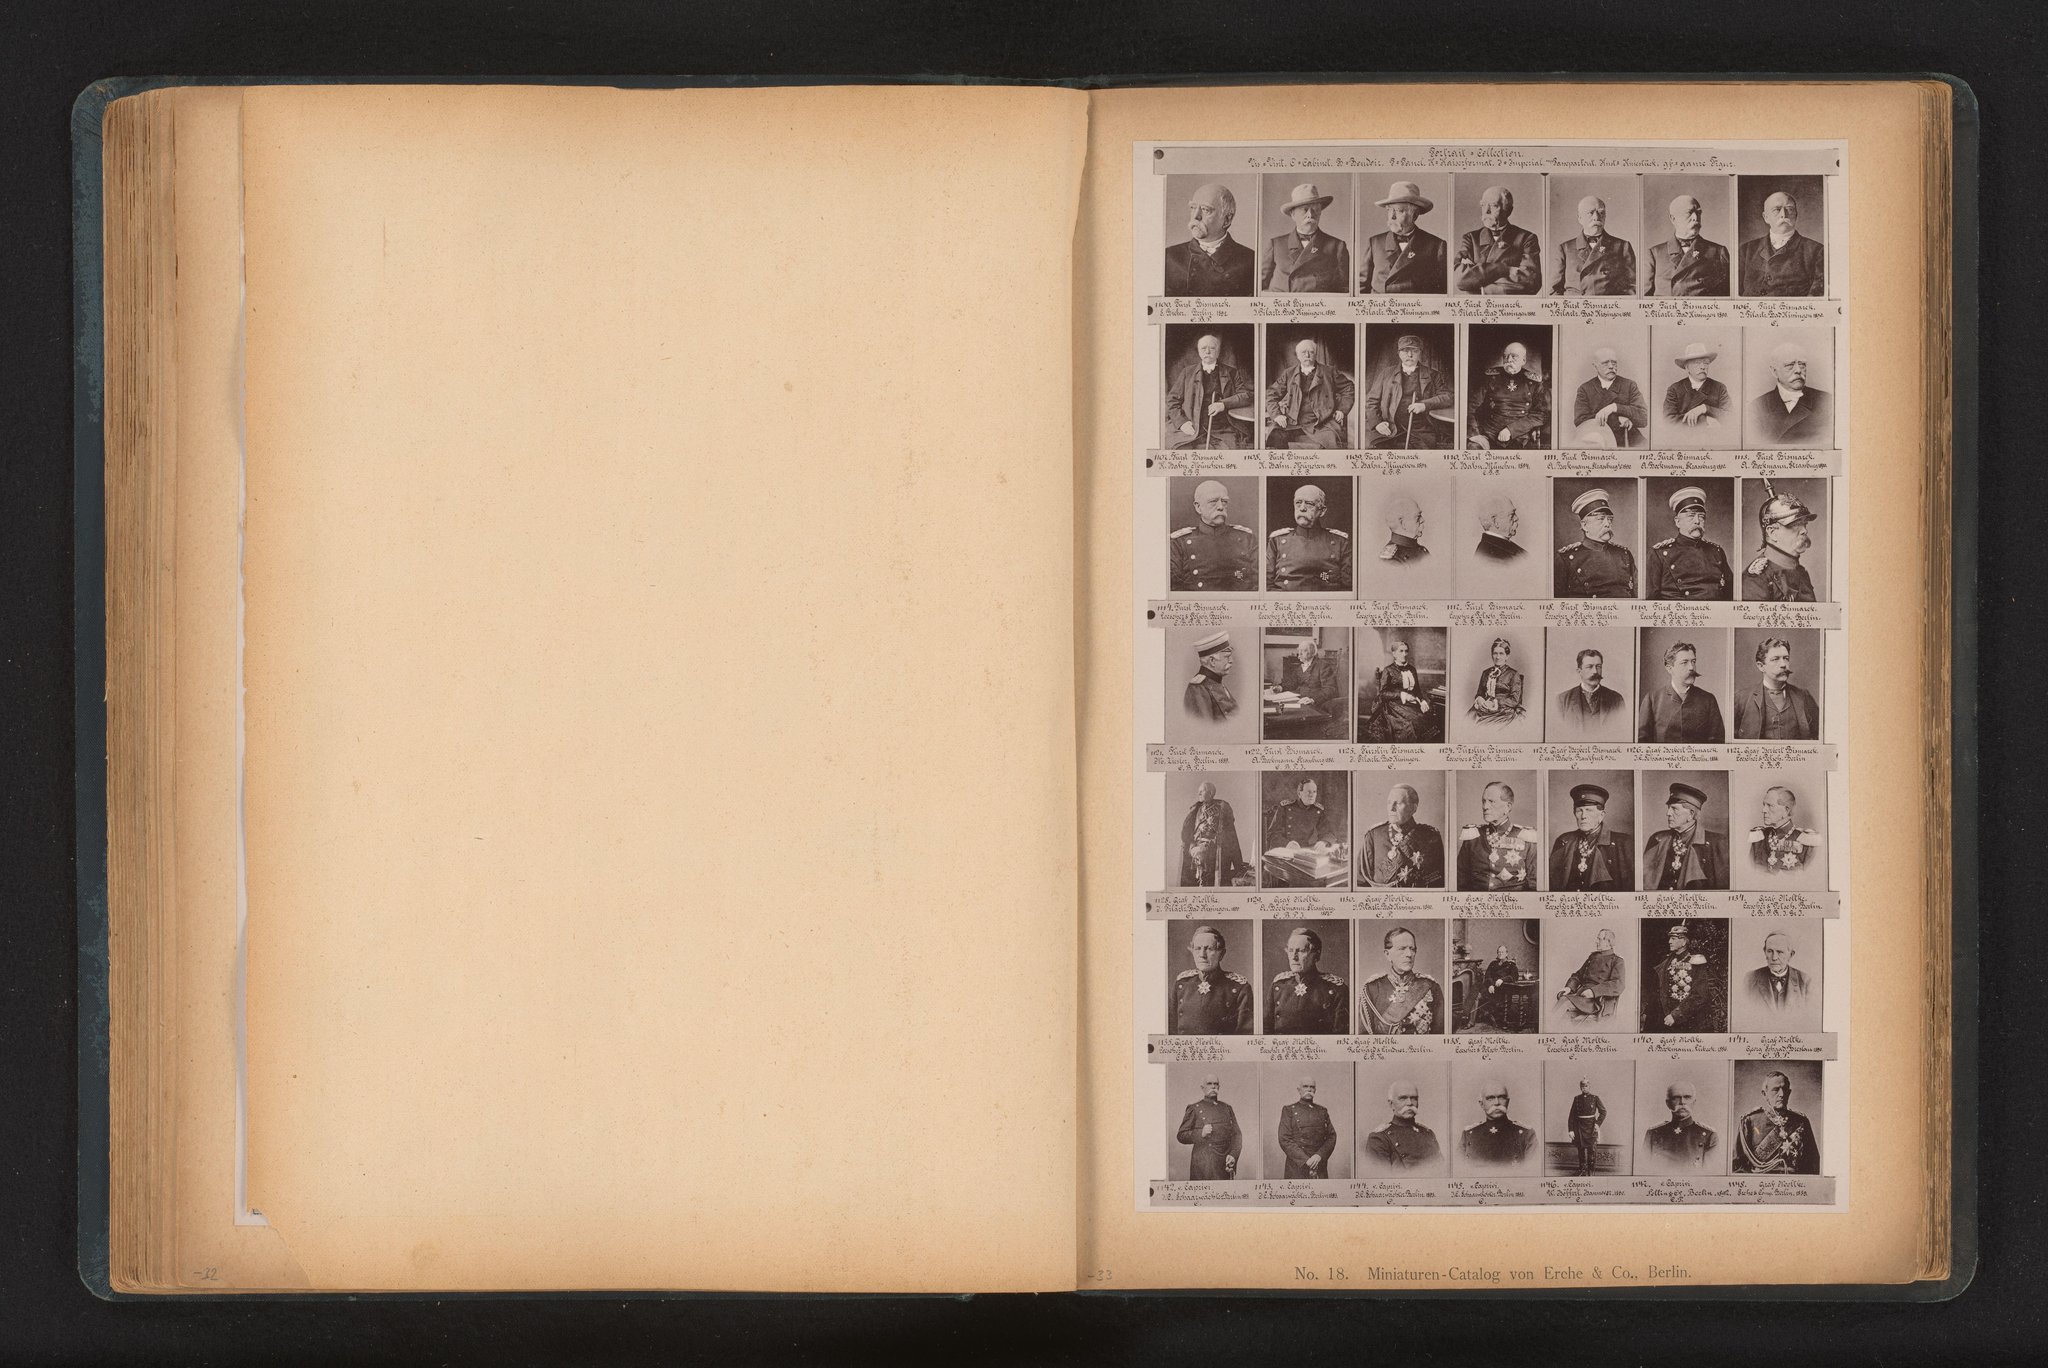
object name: photomechanical print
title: Portretten van Duitse militairen, waaronder Otto von Bismarck met zijn echtgenote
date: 1880-1885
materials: paper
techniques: photograph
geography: berlin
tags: commander-in-chief, general, marshal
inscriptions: number: ‘No. 18.’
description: Prent op drieëndertigste ongenummerde pagina.